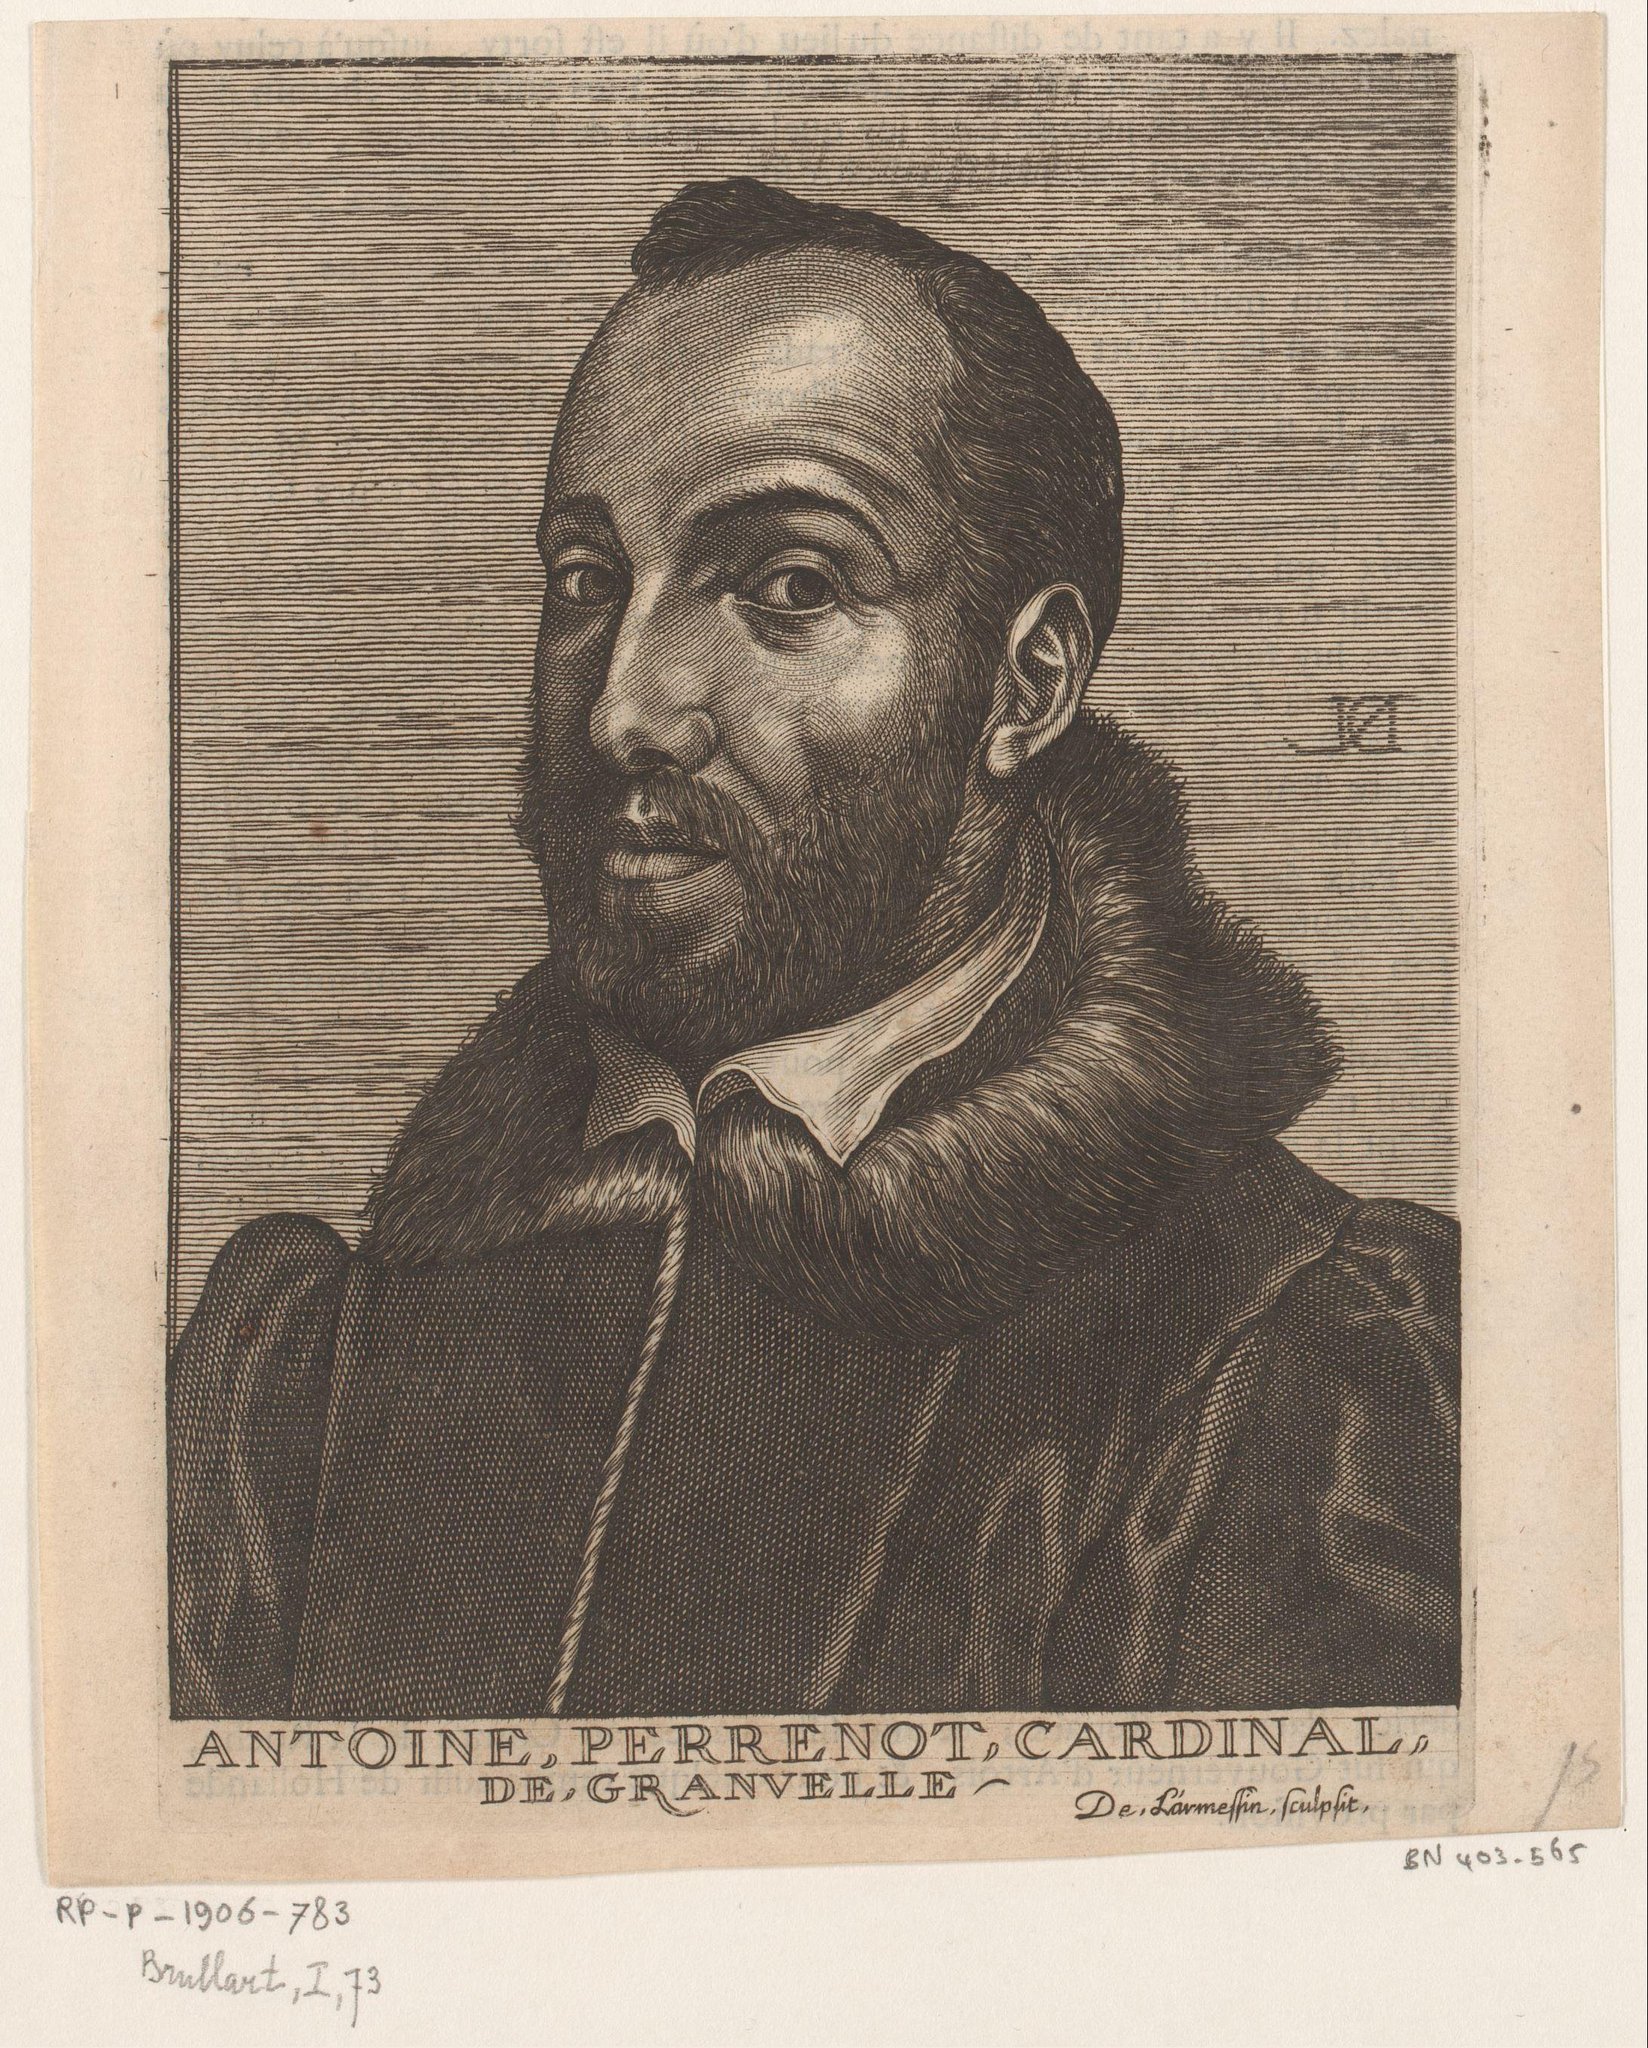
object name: book illustration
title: Portret van Antoine Perrenot de Granvelle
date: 1682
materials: paper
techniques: engraving, letterpress printing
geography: brussels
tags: antoine perrenot de granvelle, historical persons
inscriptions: collector's mark: Lugt 2228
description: Prent gebruikt voor: Bullart, Isaac. Académie des Sciences et Arts contenant les vies et éloges his. des hommes illustres qui ont excellé en ces professions depuis environ quatre siècles. Brussel: François Foppens, 1682. Het boek werd in 1682 eveneens in Amsterdam uitgegeven door de erfgenamen van Daniel Elzevier. Ieder portret betreft een illustratie bij de biografie van een kunstenaar of geleerde. De meeste portretten werden door Nicolas de Larmessin vervaardigd (162), 93 door De Boulonois en een derde door ongeïdentificeerde prentmakers. Dit betreft een illustratie op p. 273, deel I.